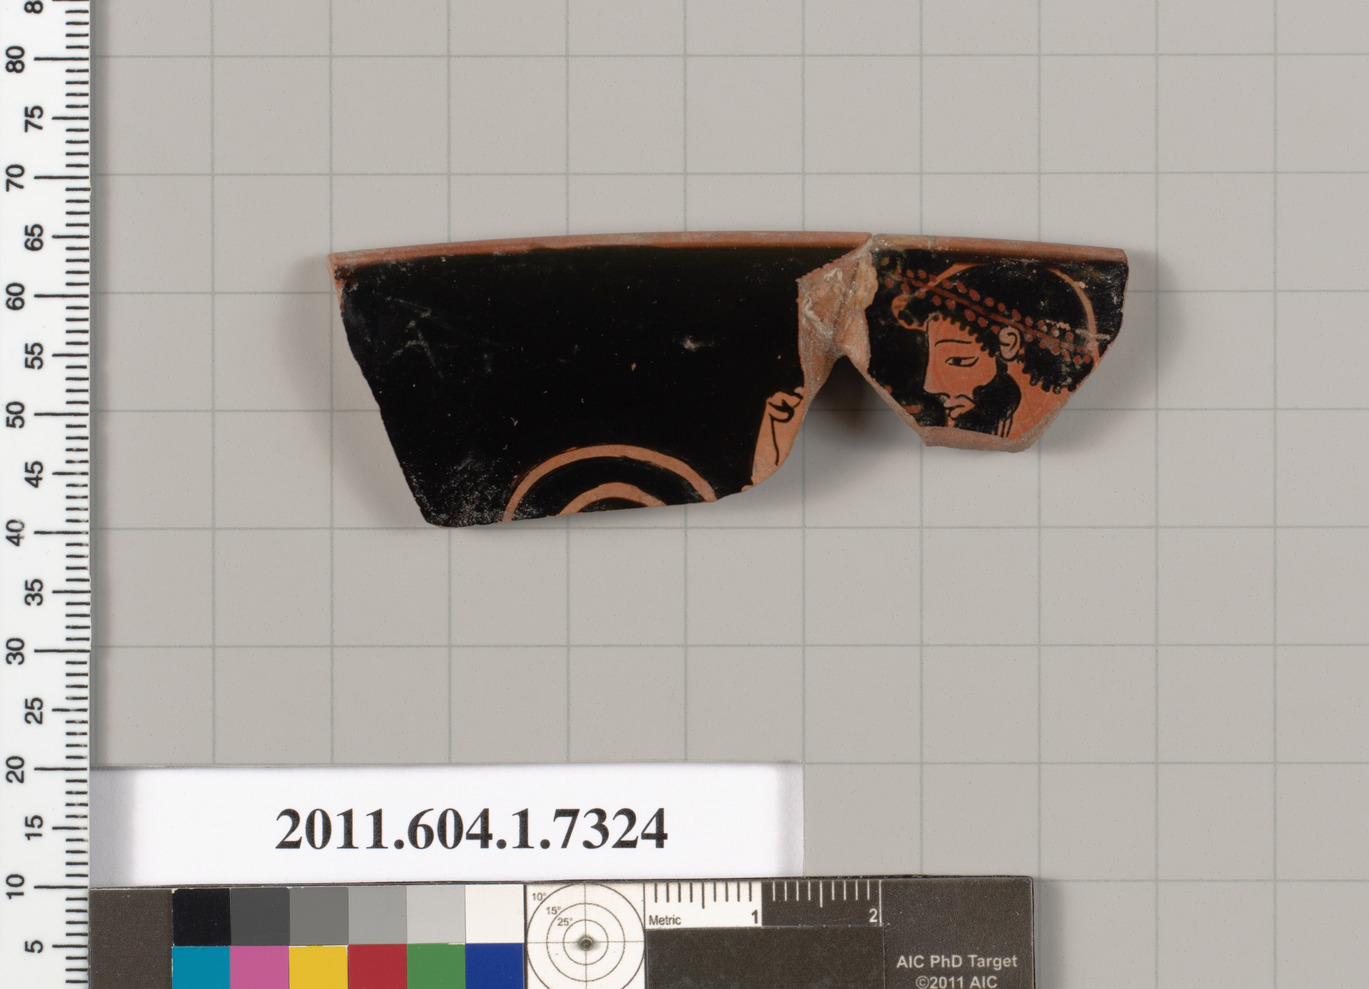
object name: kylix fragment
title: Terracotta rim fragment of a kylix (drinking cup)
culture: greek, attic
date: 500-480 BCE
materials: terracotta